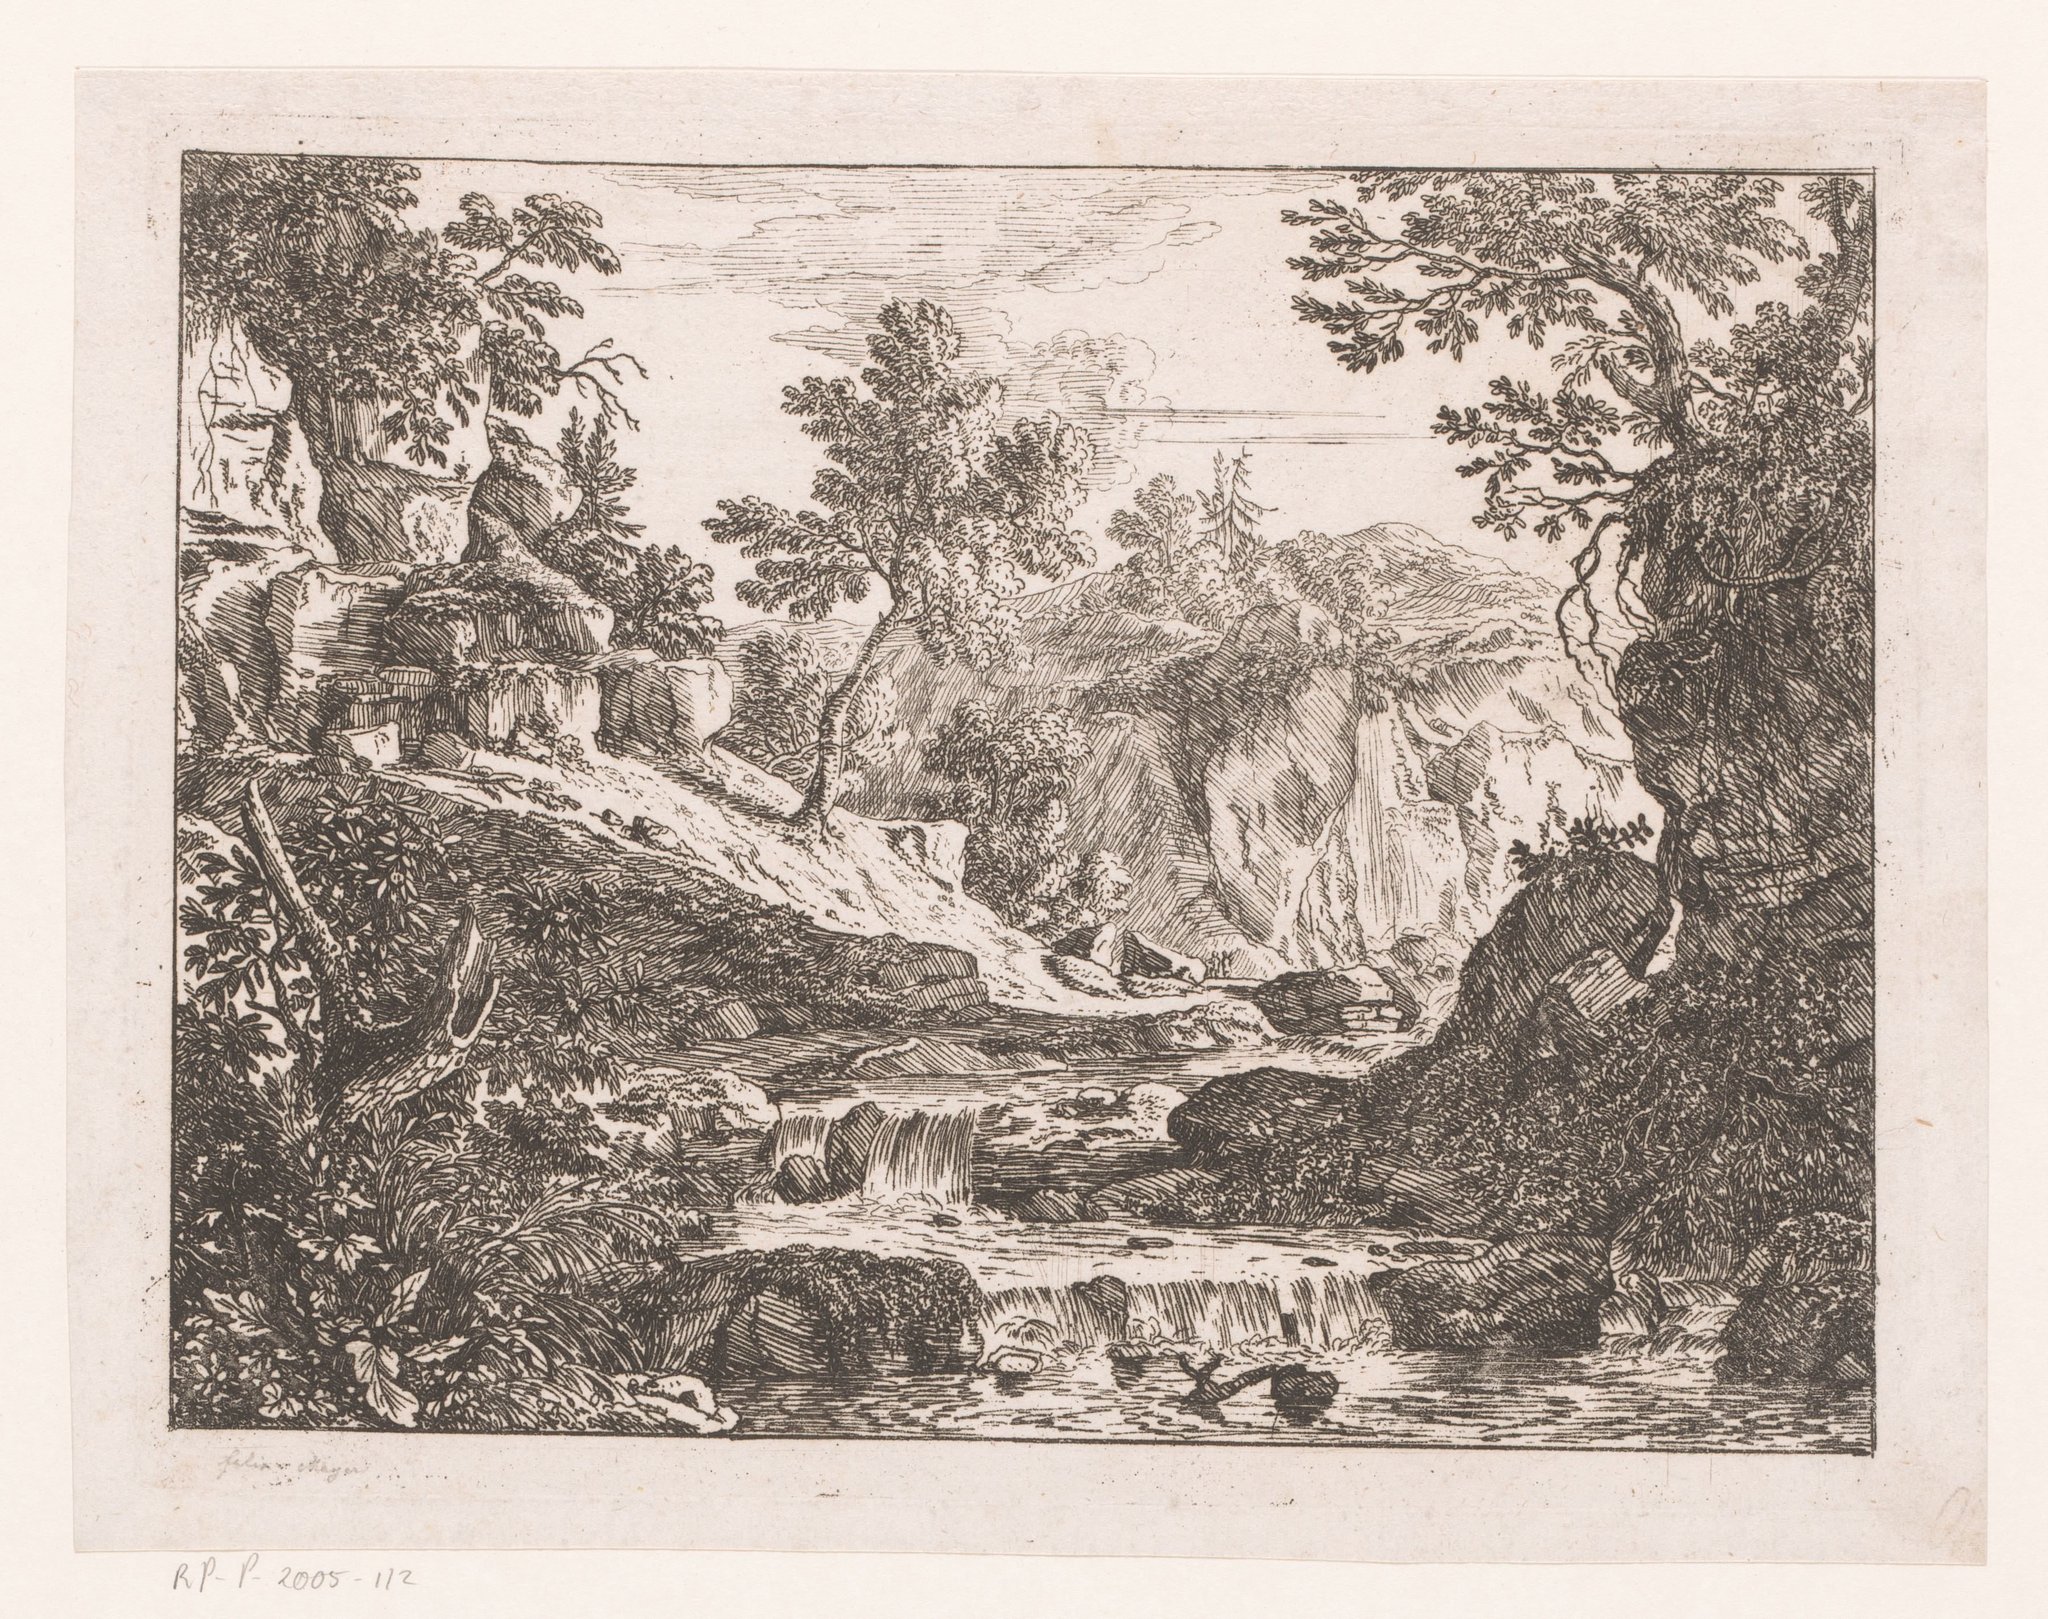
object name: print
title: Landschap met watervallen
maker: felix meyer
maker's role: print maker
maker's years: 1653-1713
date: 1663-1713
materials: paper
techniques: etching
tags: waterfall, landscapes with waters, waterscapes, seascapes (in the temperate zone)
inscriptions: collector's mark: Lugt 2228